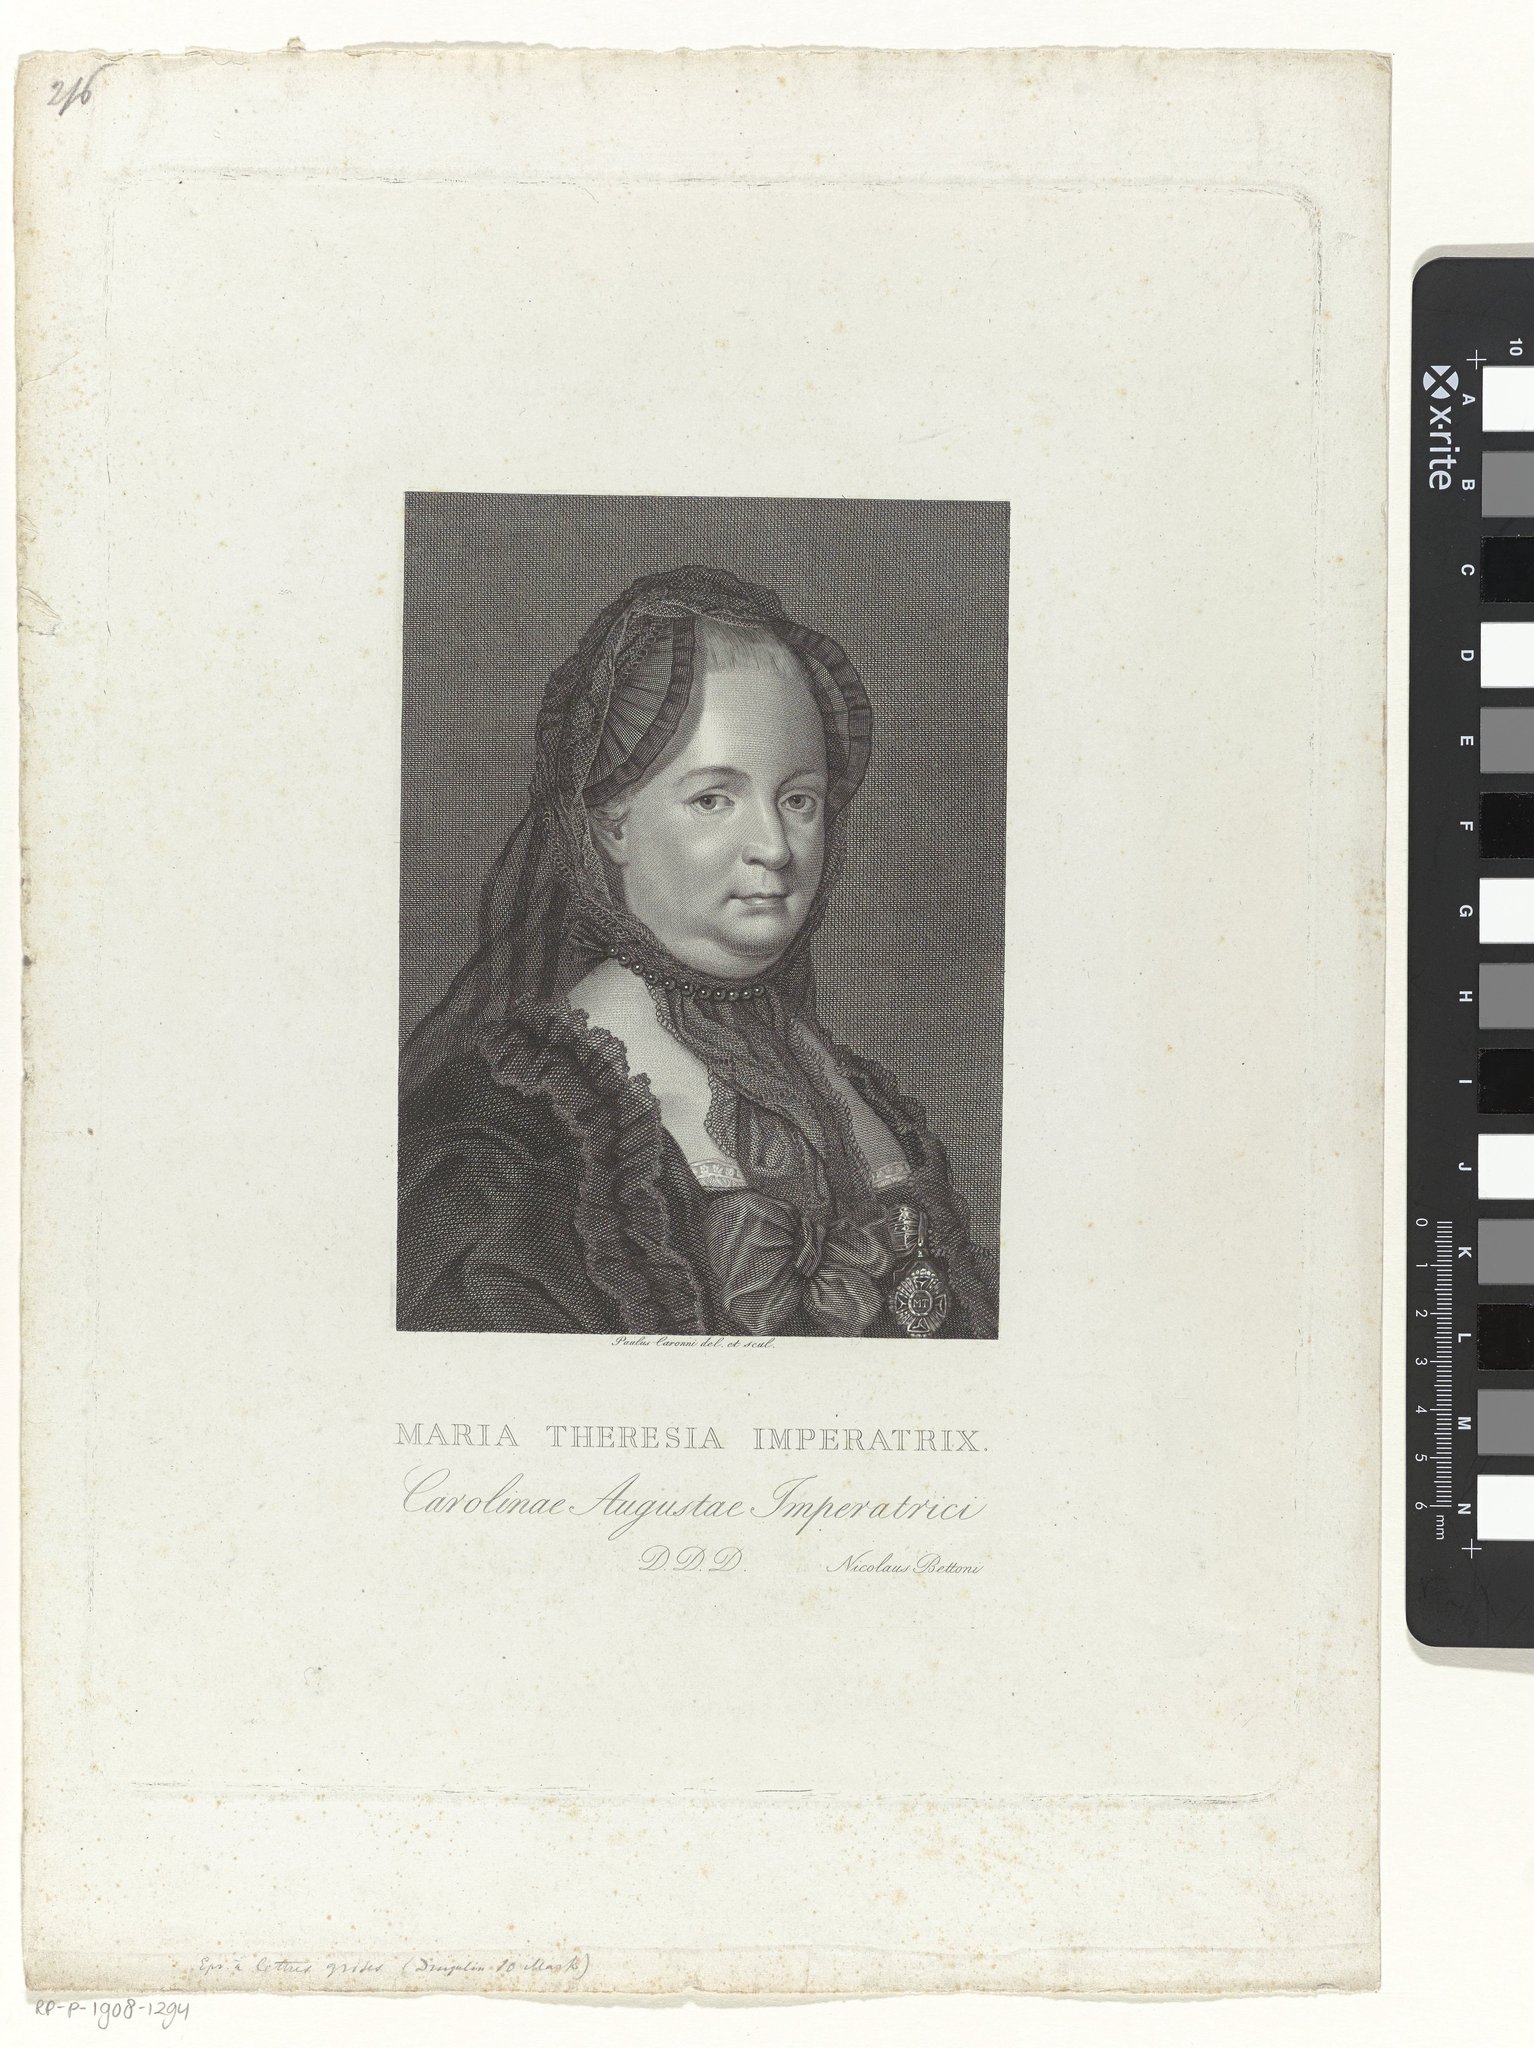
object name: print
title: Portret van Maria Theresia van Oostenrijk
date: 1789-1842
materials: paper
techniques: engraving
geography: italy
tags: vienna, maria theresia (rooms-duits keizerin), historical persons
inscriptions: collector's mark: Lugt 2228